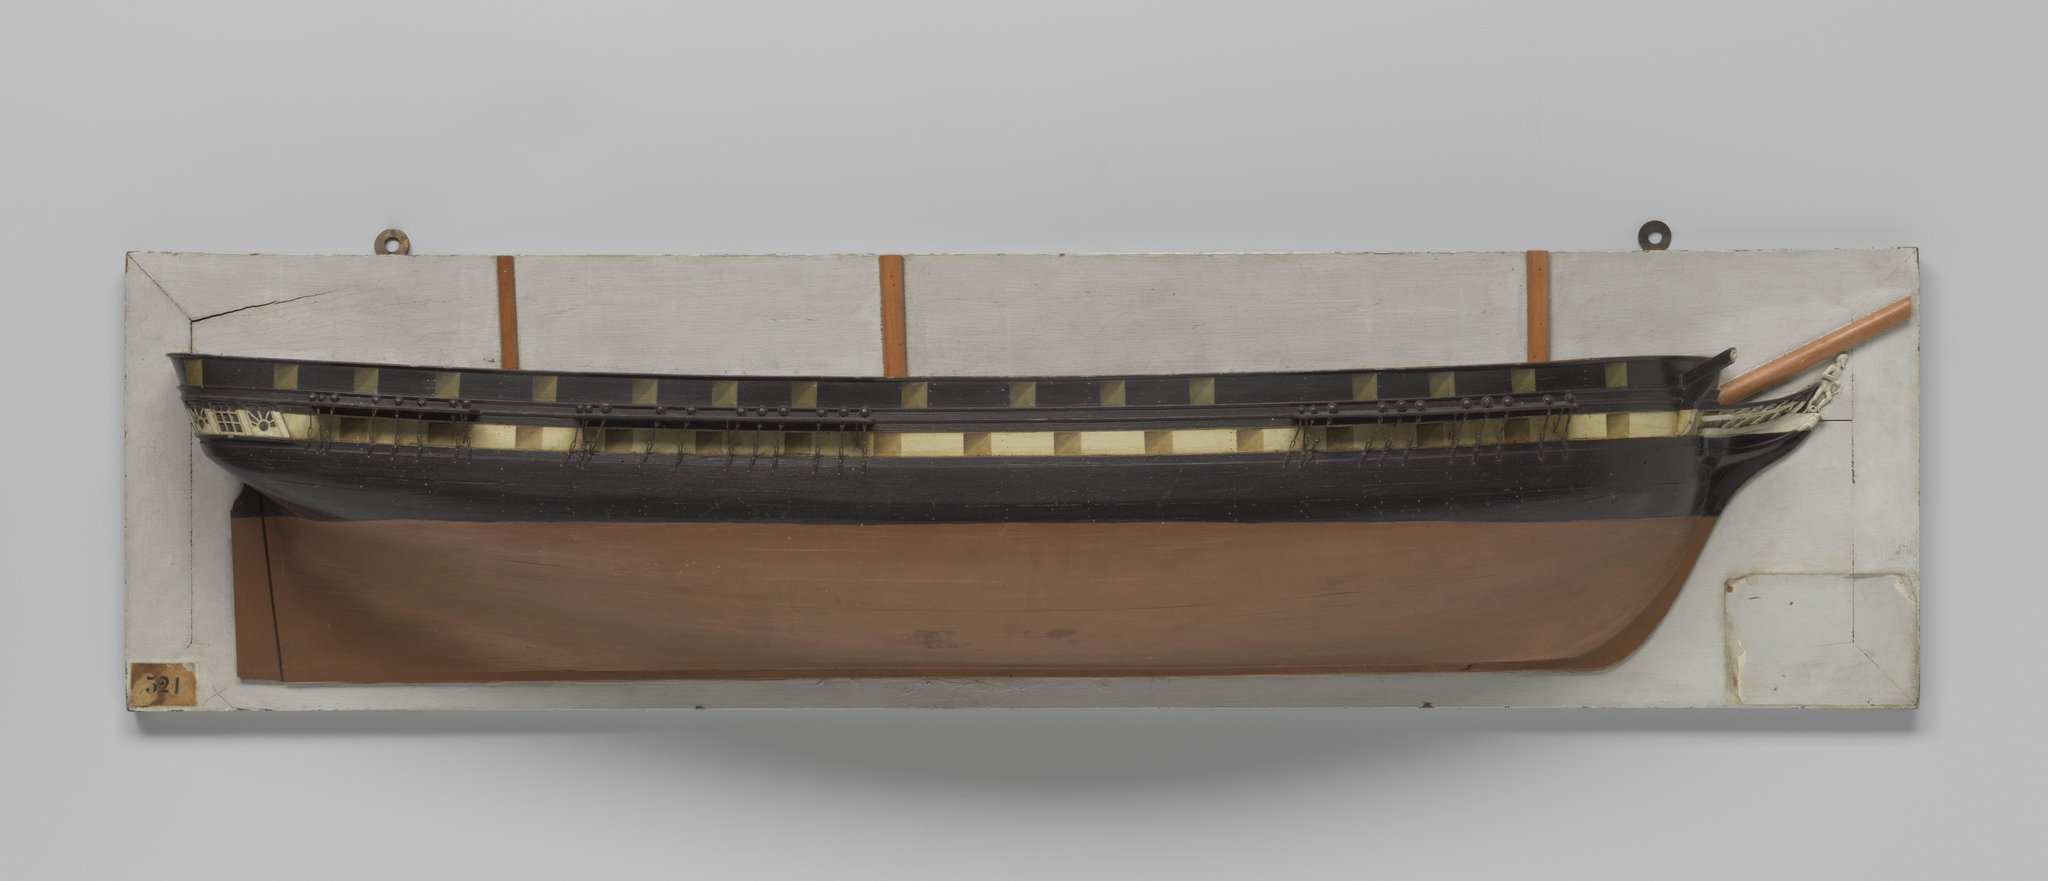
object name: ship model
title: Half Model of a 60-Gun Frigate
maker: Anonymous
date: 1828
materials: brass, wood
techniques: polychromy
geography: netherlands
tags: waal (schip), prins van oranje (schip)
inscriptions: label, bottom left: ‘321’ former inventory label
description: Gepolychromeerd mallenmodel (stuurboord) van een driemaster. Vier en dertig geschutpoorten op twee dekken. Het schegbeeld is een man in loophouding. Op de kraanbalk een leeuwenkop. Achterschip met elliptisch hek van één verdieping zonder zijgalerij, daarboven een open geschutdek; recht roer met vierkante roerkoning. De zeeg loopt iets op aan beide uiteinden, één barkhout en twee reehouten. Het model is van alle rusten met jufferblokken voorzien. Gepiekt rondspant. Schaal 1:50 (schaal op model).